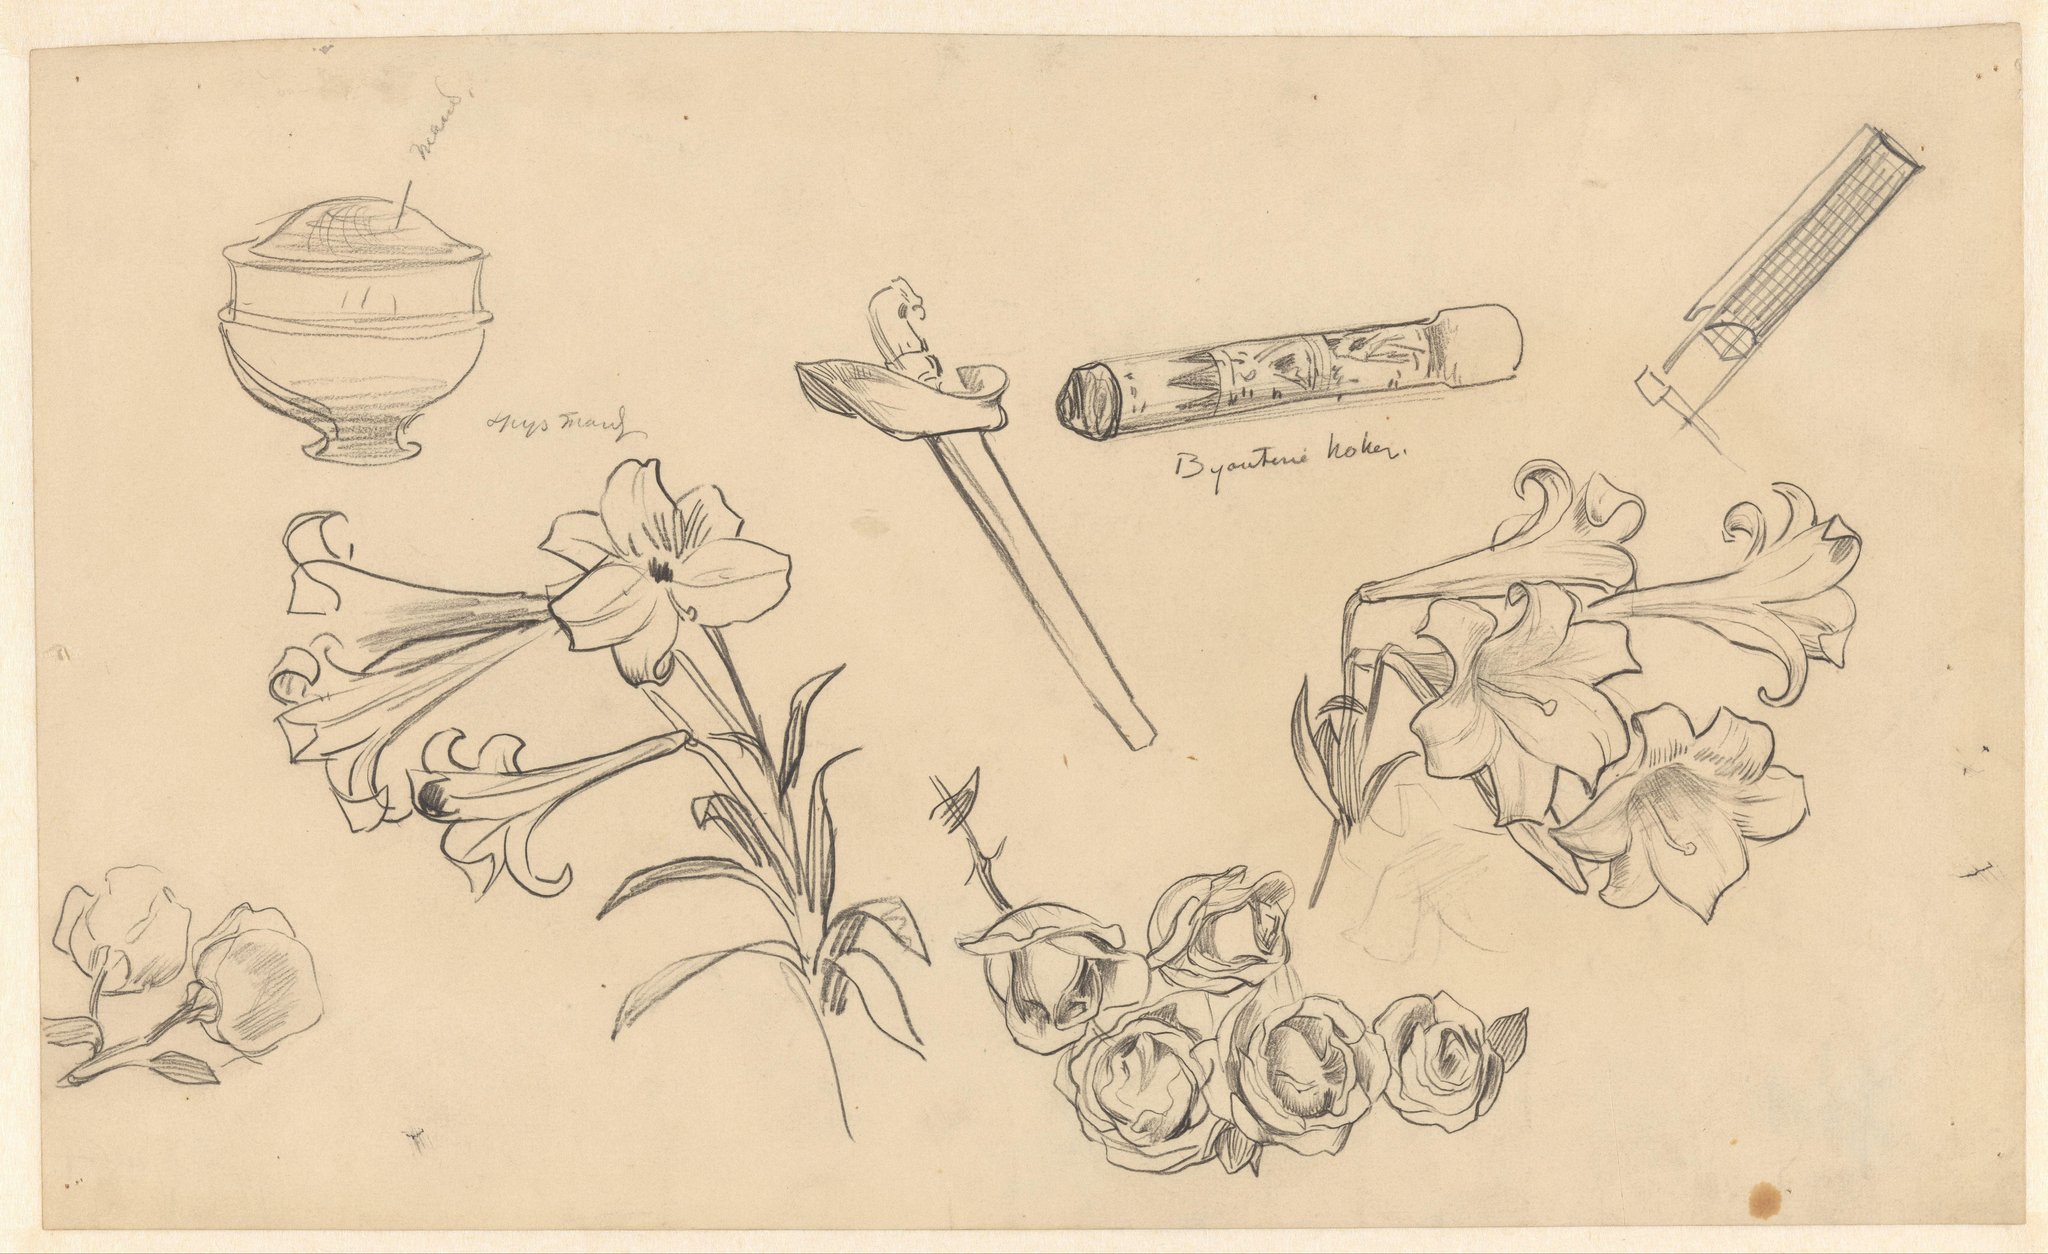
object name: drawing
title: Studieblad met rozen, lelies en voorwerpen zoals een kris en juwelenkoker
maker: nicolaas van der waay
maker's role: draughtsman, painter, print maker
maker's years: 1855-1936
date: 1865-1936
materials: chalk, paper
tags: containers, hacking and thrusting weapons, flowers: lily, flowers: rose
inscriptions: number: ‘973’, collector's mark: Lugt 2760, collector's mark: Lugt 2228, annotation: ‘[...]J [...]7/30’